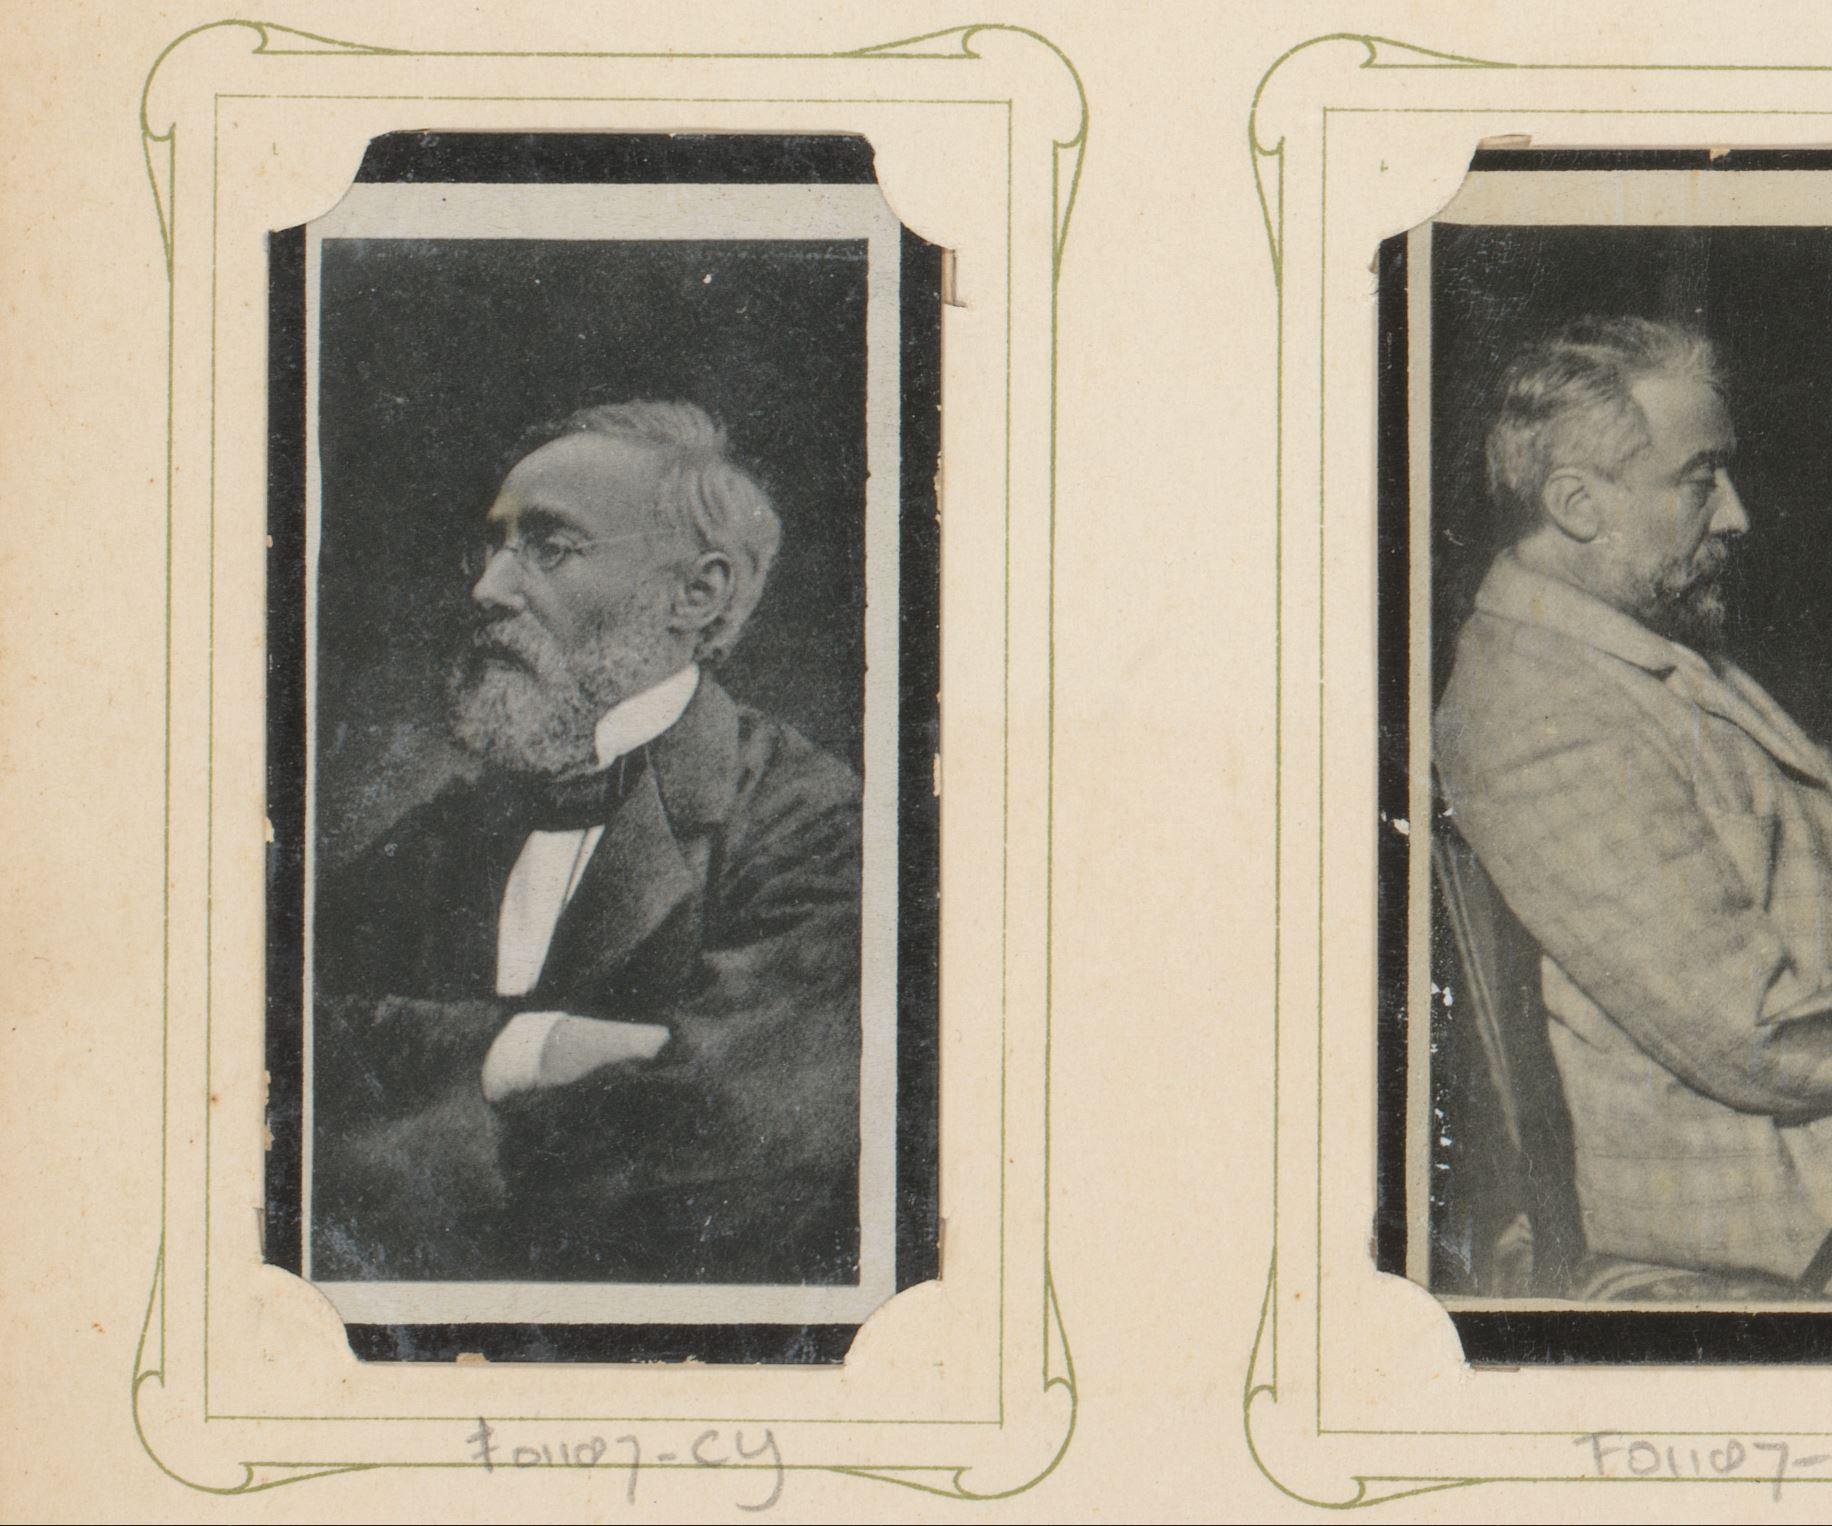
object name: album leaf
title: Portret van Jozef Israëls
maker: Anonymous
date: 1905-1906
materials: paper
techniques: photograph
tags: the hague, painter, draughtsman, jozef israëls, historical persons, portrait, self-portrait of painter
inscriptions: inscription: ‘No. 4./ Israëls.’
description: Deze prent maakt deel uit van een album.